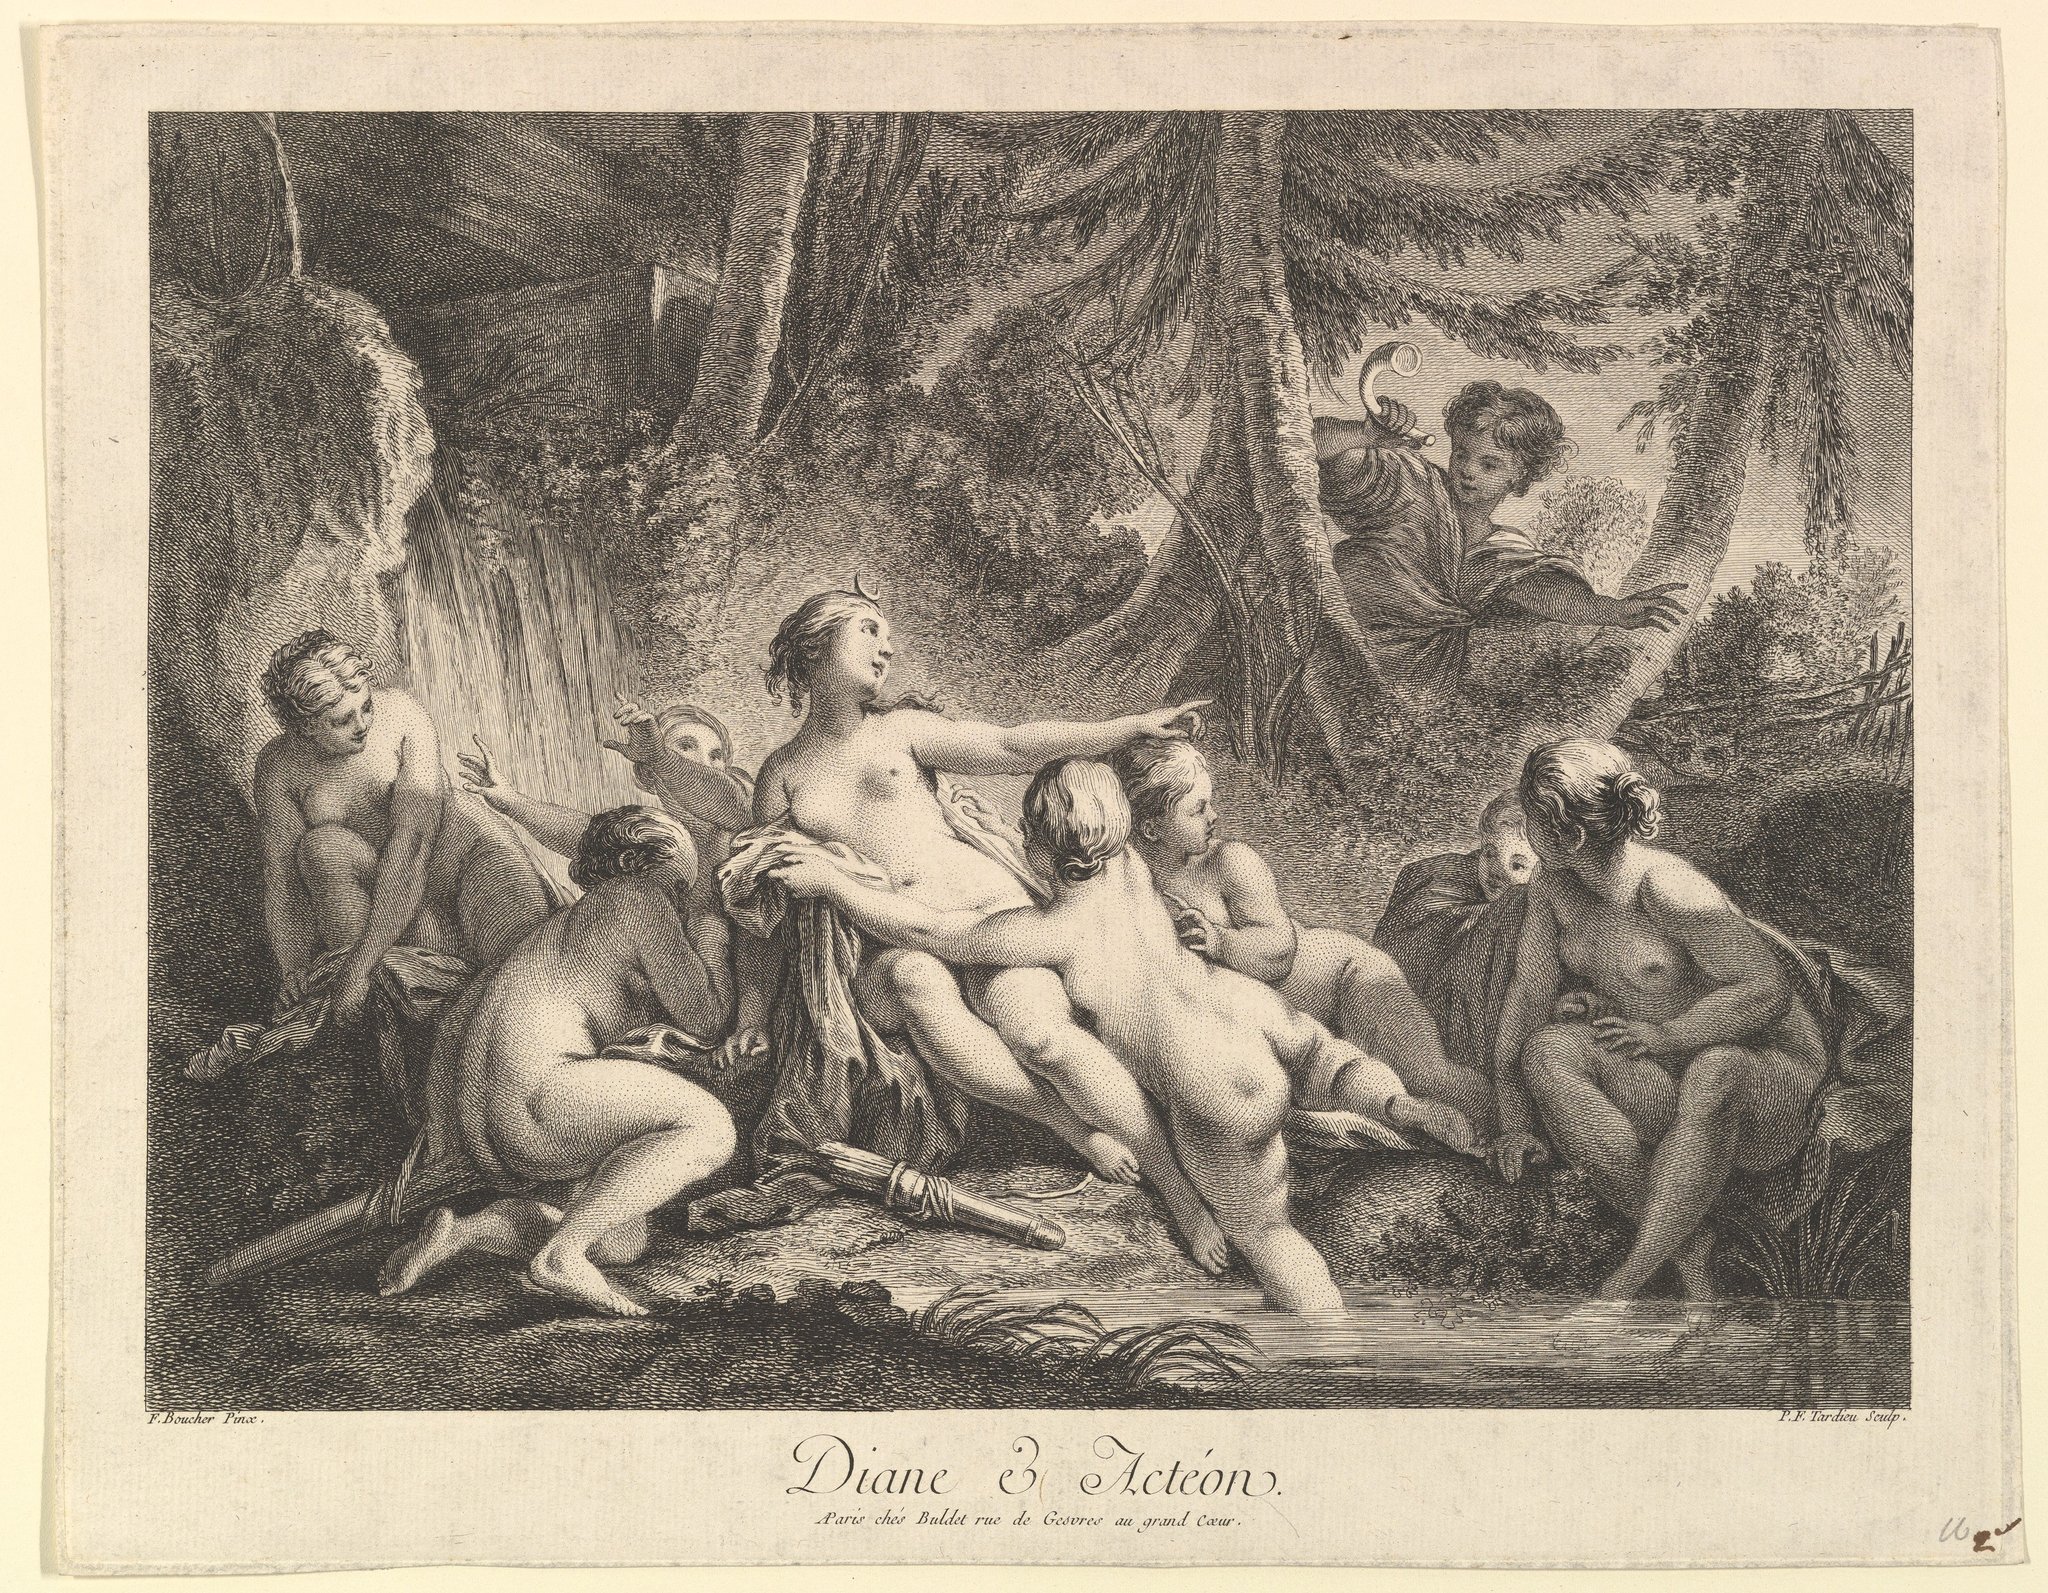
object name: print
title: Diana and Acteon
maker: pierre françois tardieu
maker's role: artist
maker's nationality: french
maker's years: 1711-1771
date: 1711-1771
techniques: engraving, etching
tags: boys,female nudes,horns,diana